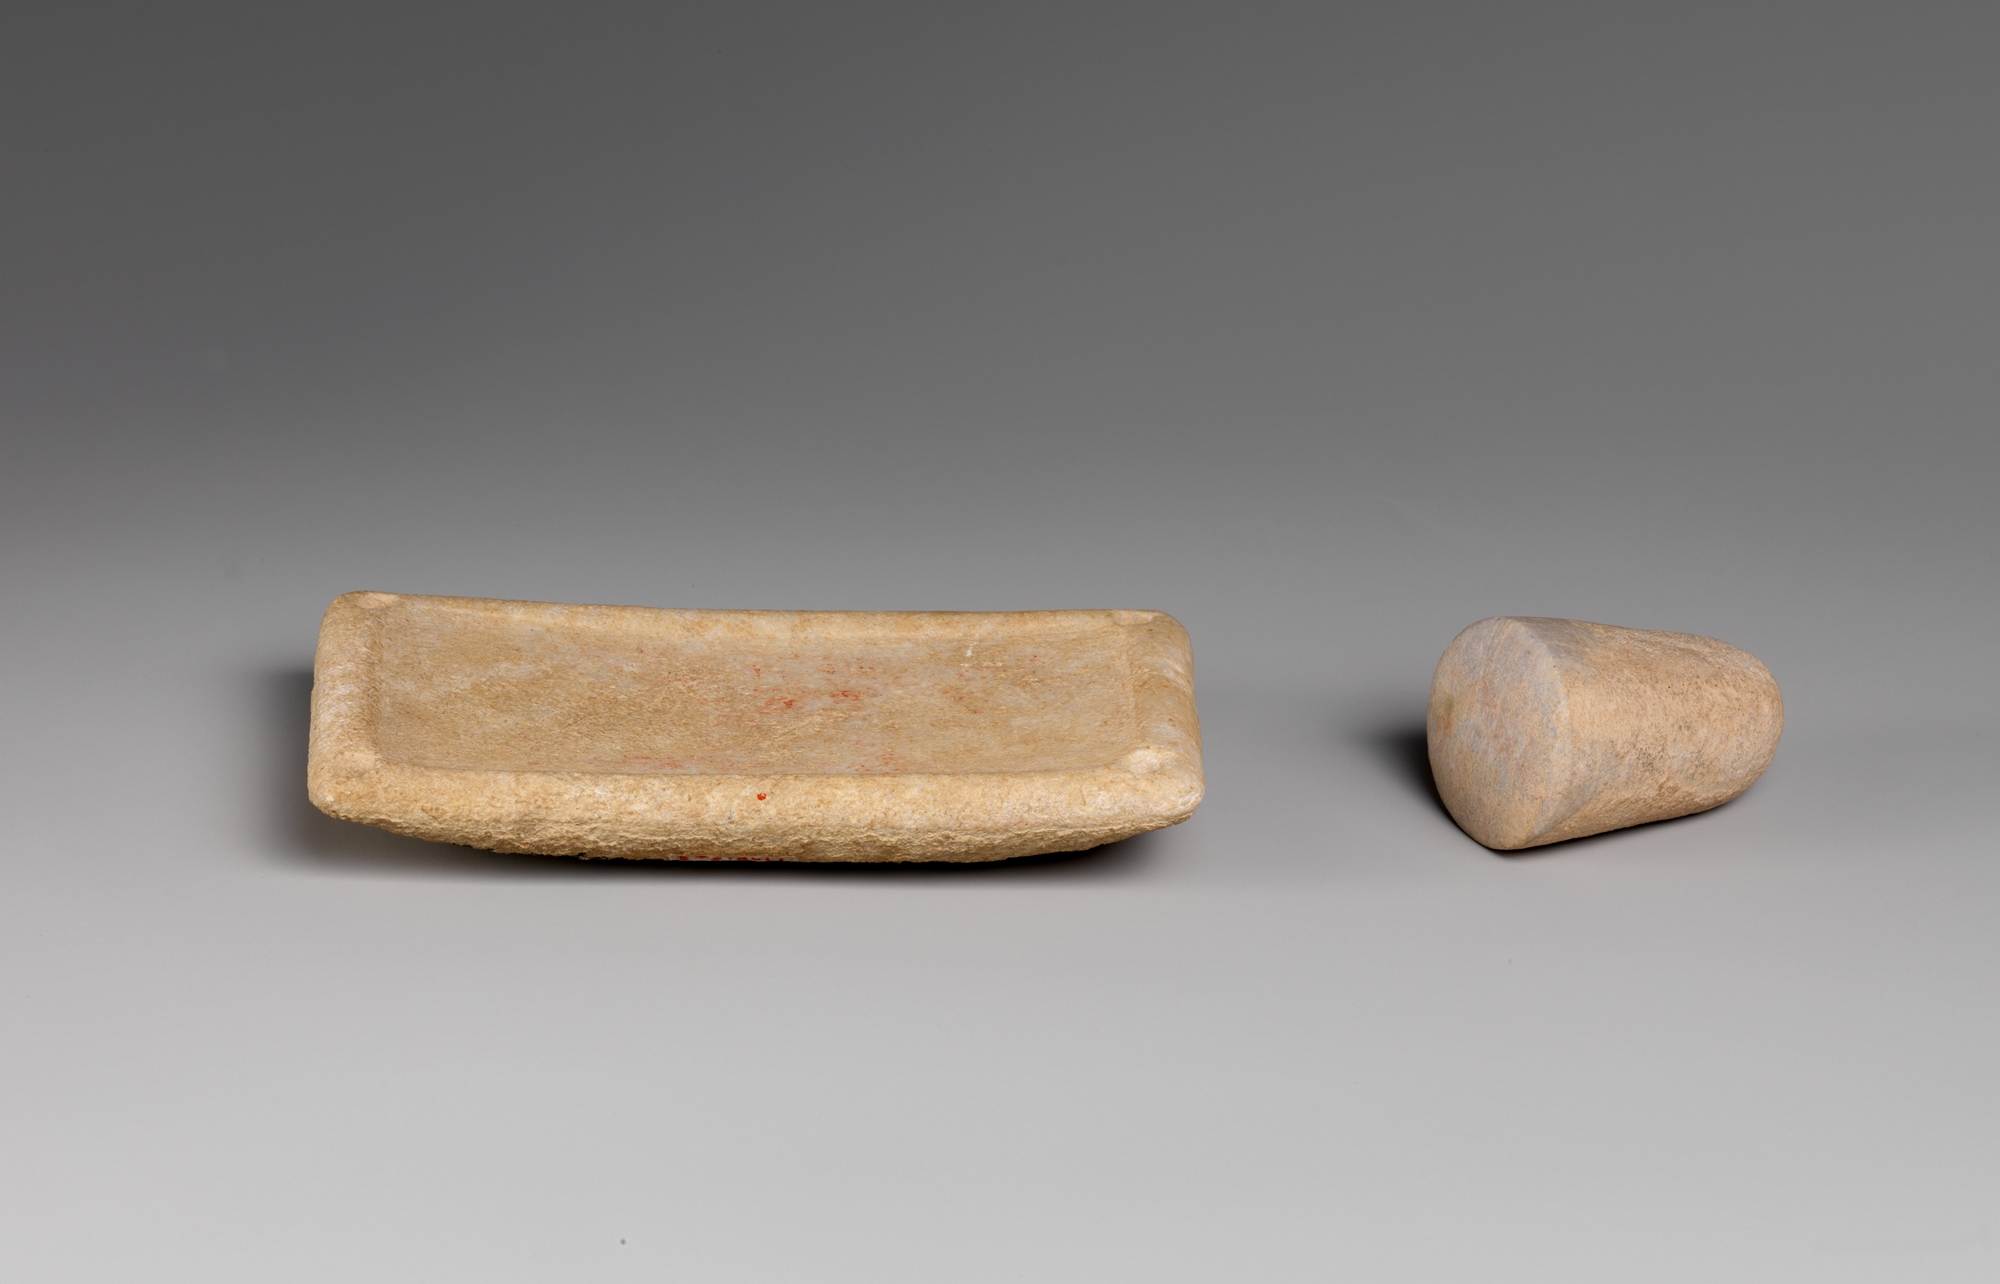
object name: pestle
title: Marble pestle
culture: cycladic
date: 2700-2200 BCE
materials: marble